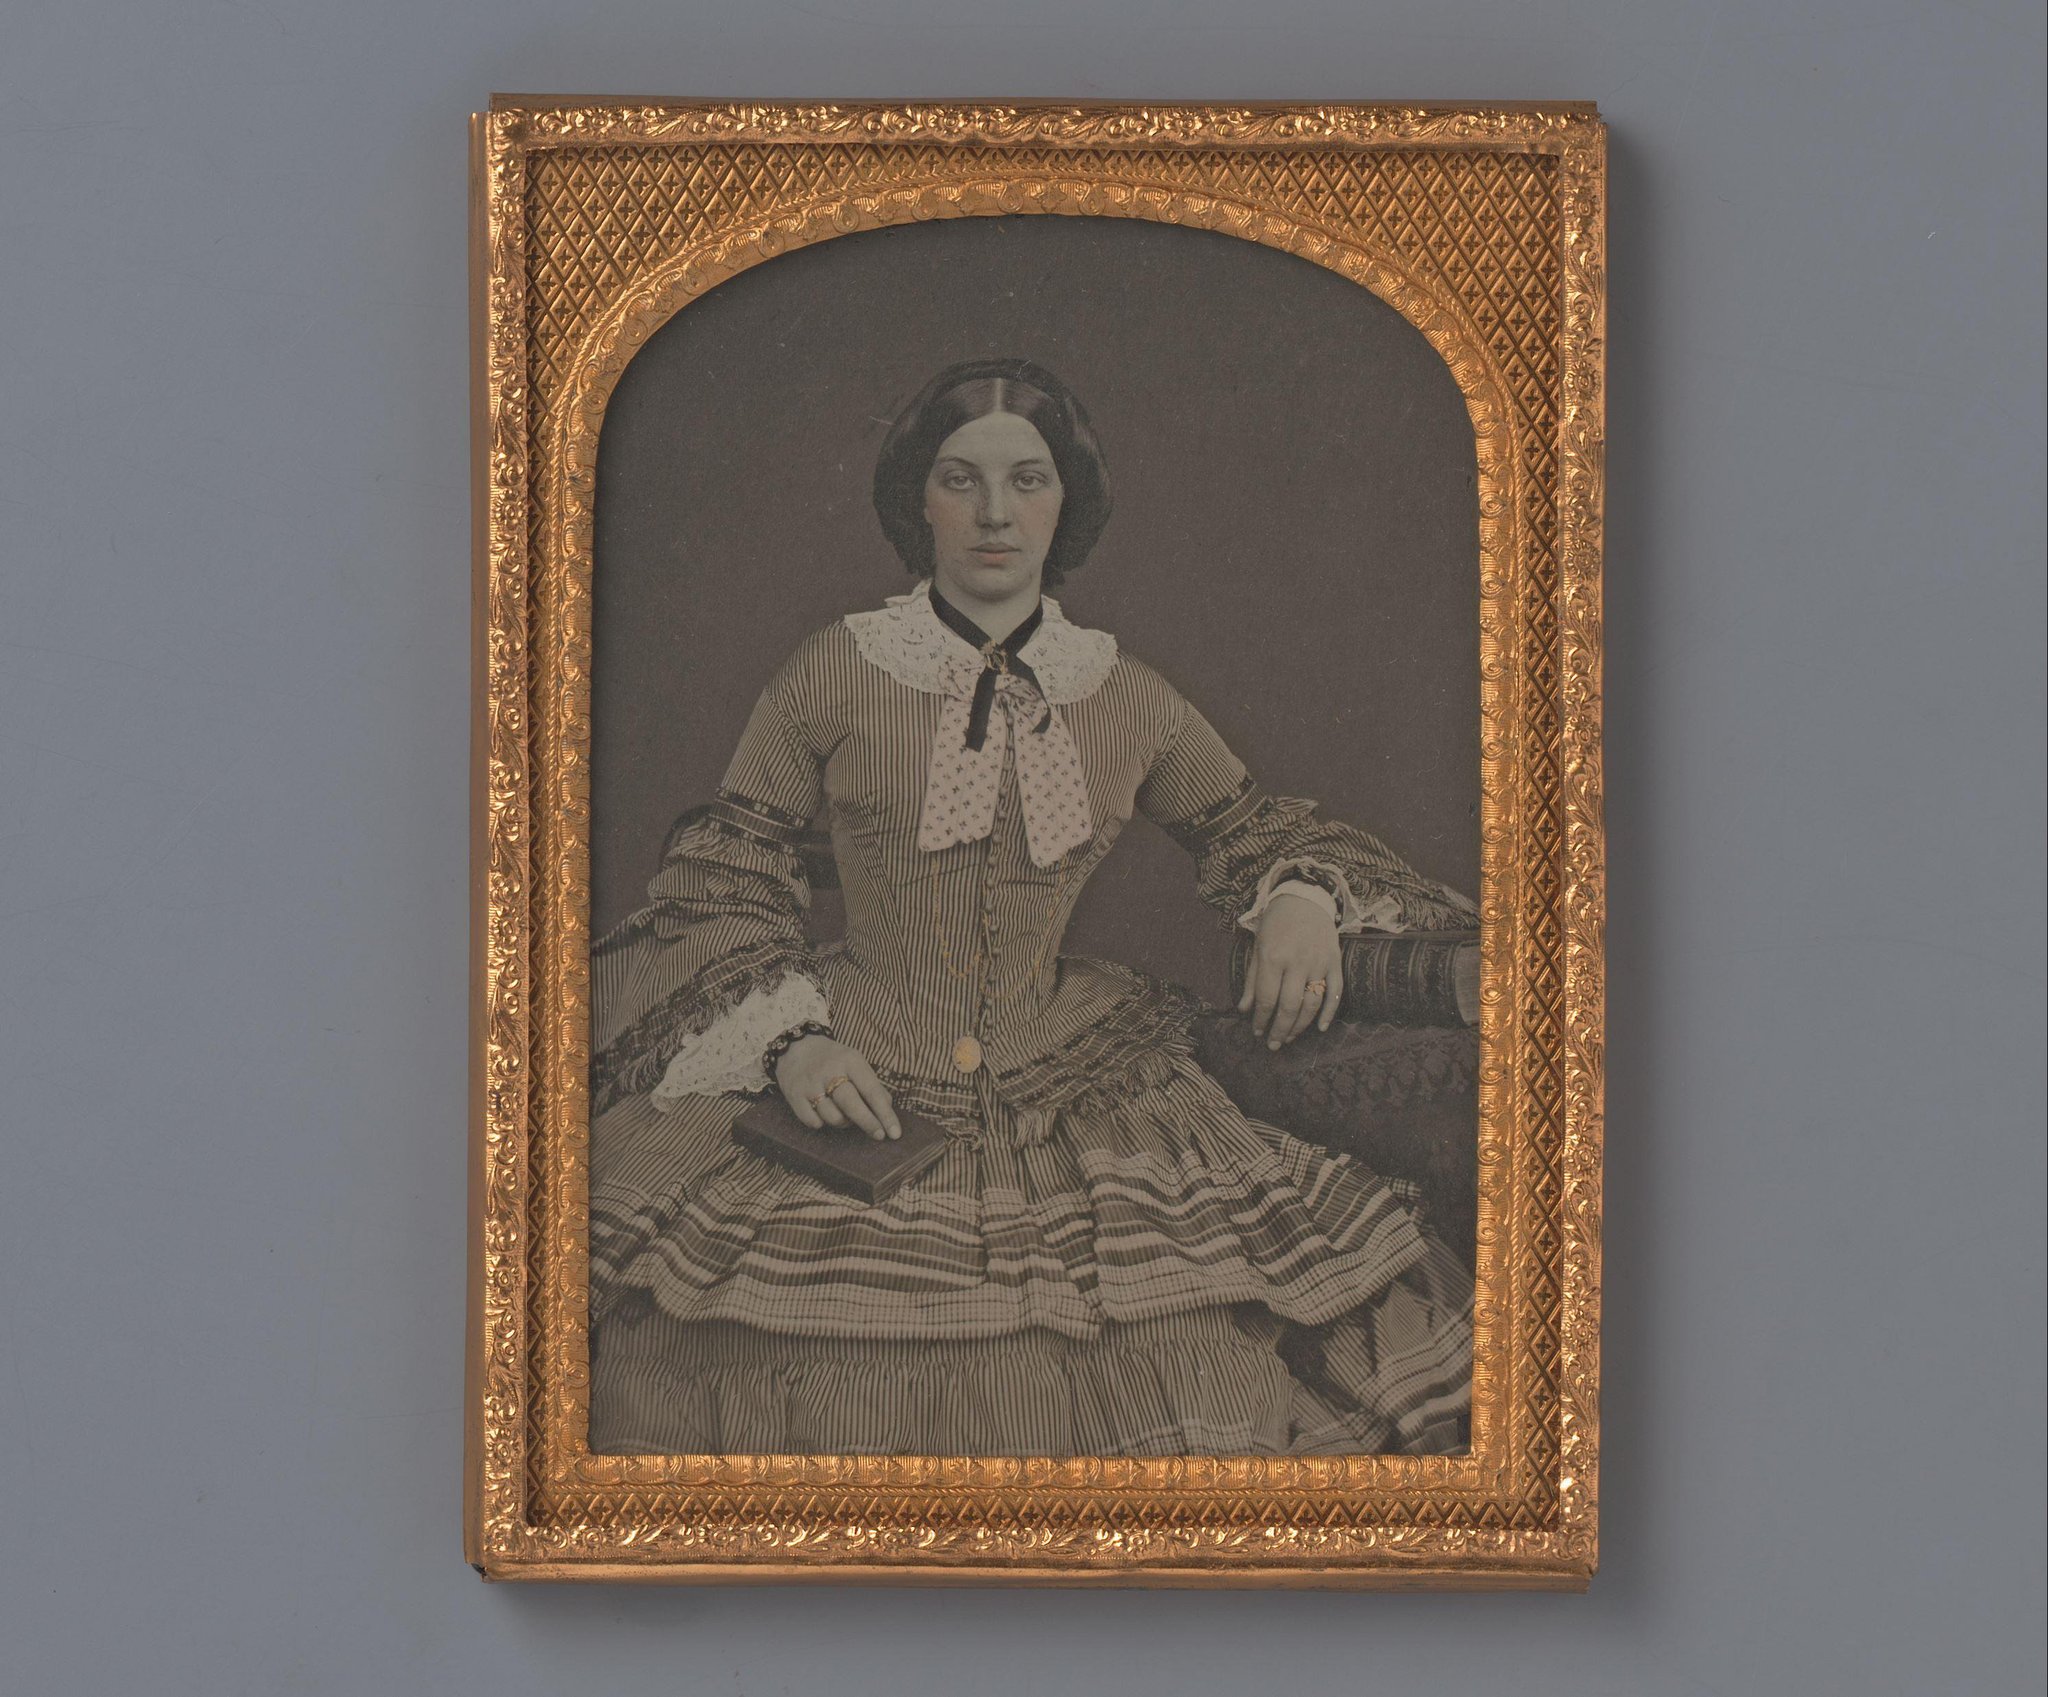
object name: photograph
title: Portret van een jonge vrouw met een boek op schoot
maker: Anonymous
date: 1855-1870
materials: glass, metal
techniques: ambrotype, hand coloring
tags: sitting figure - aa - female human figure, historical persons, book